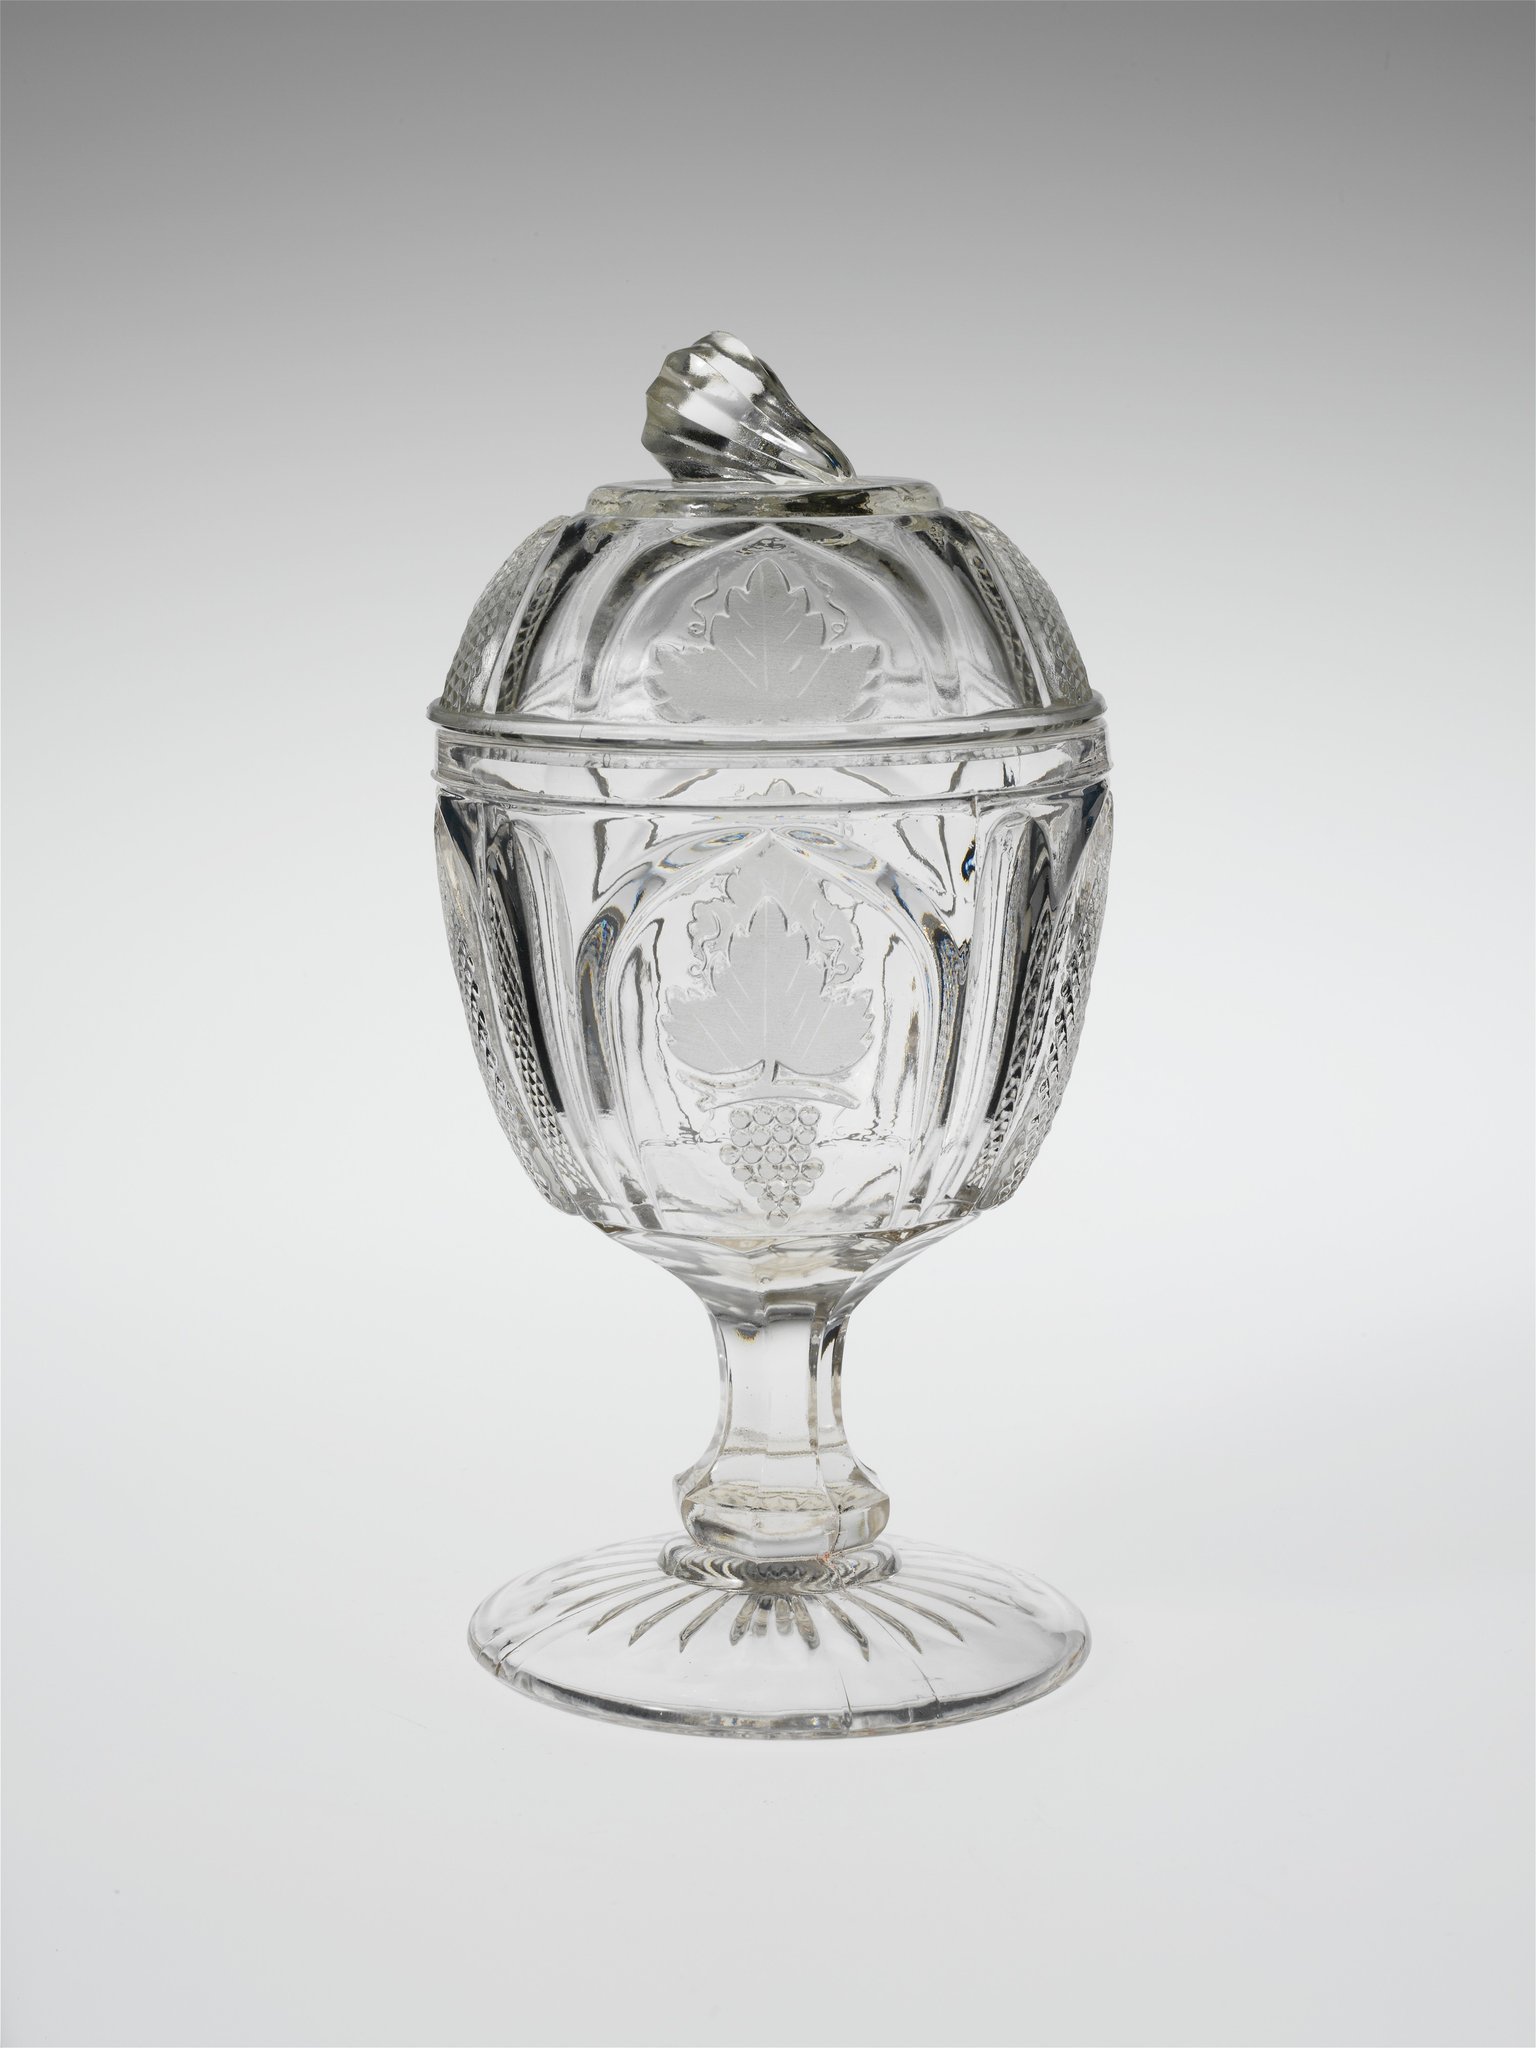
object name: sugar bowl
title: Covered Sugar Bowl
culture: american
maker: boston & sandwich glass company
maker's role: maker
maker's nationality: american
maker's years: 1825-1888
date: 1830-1870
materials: glass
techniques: pressed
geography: united states